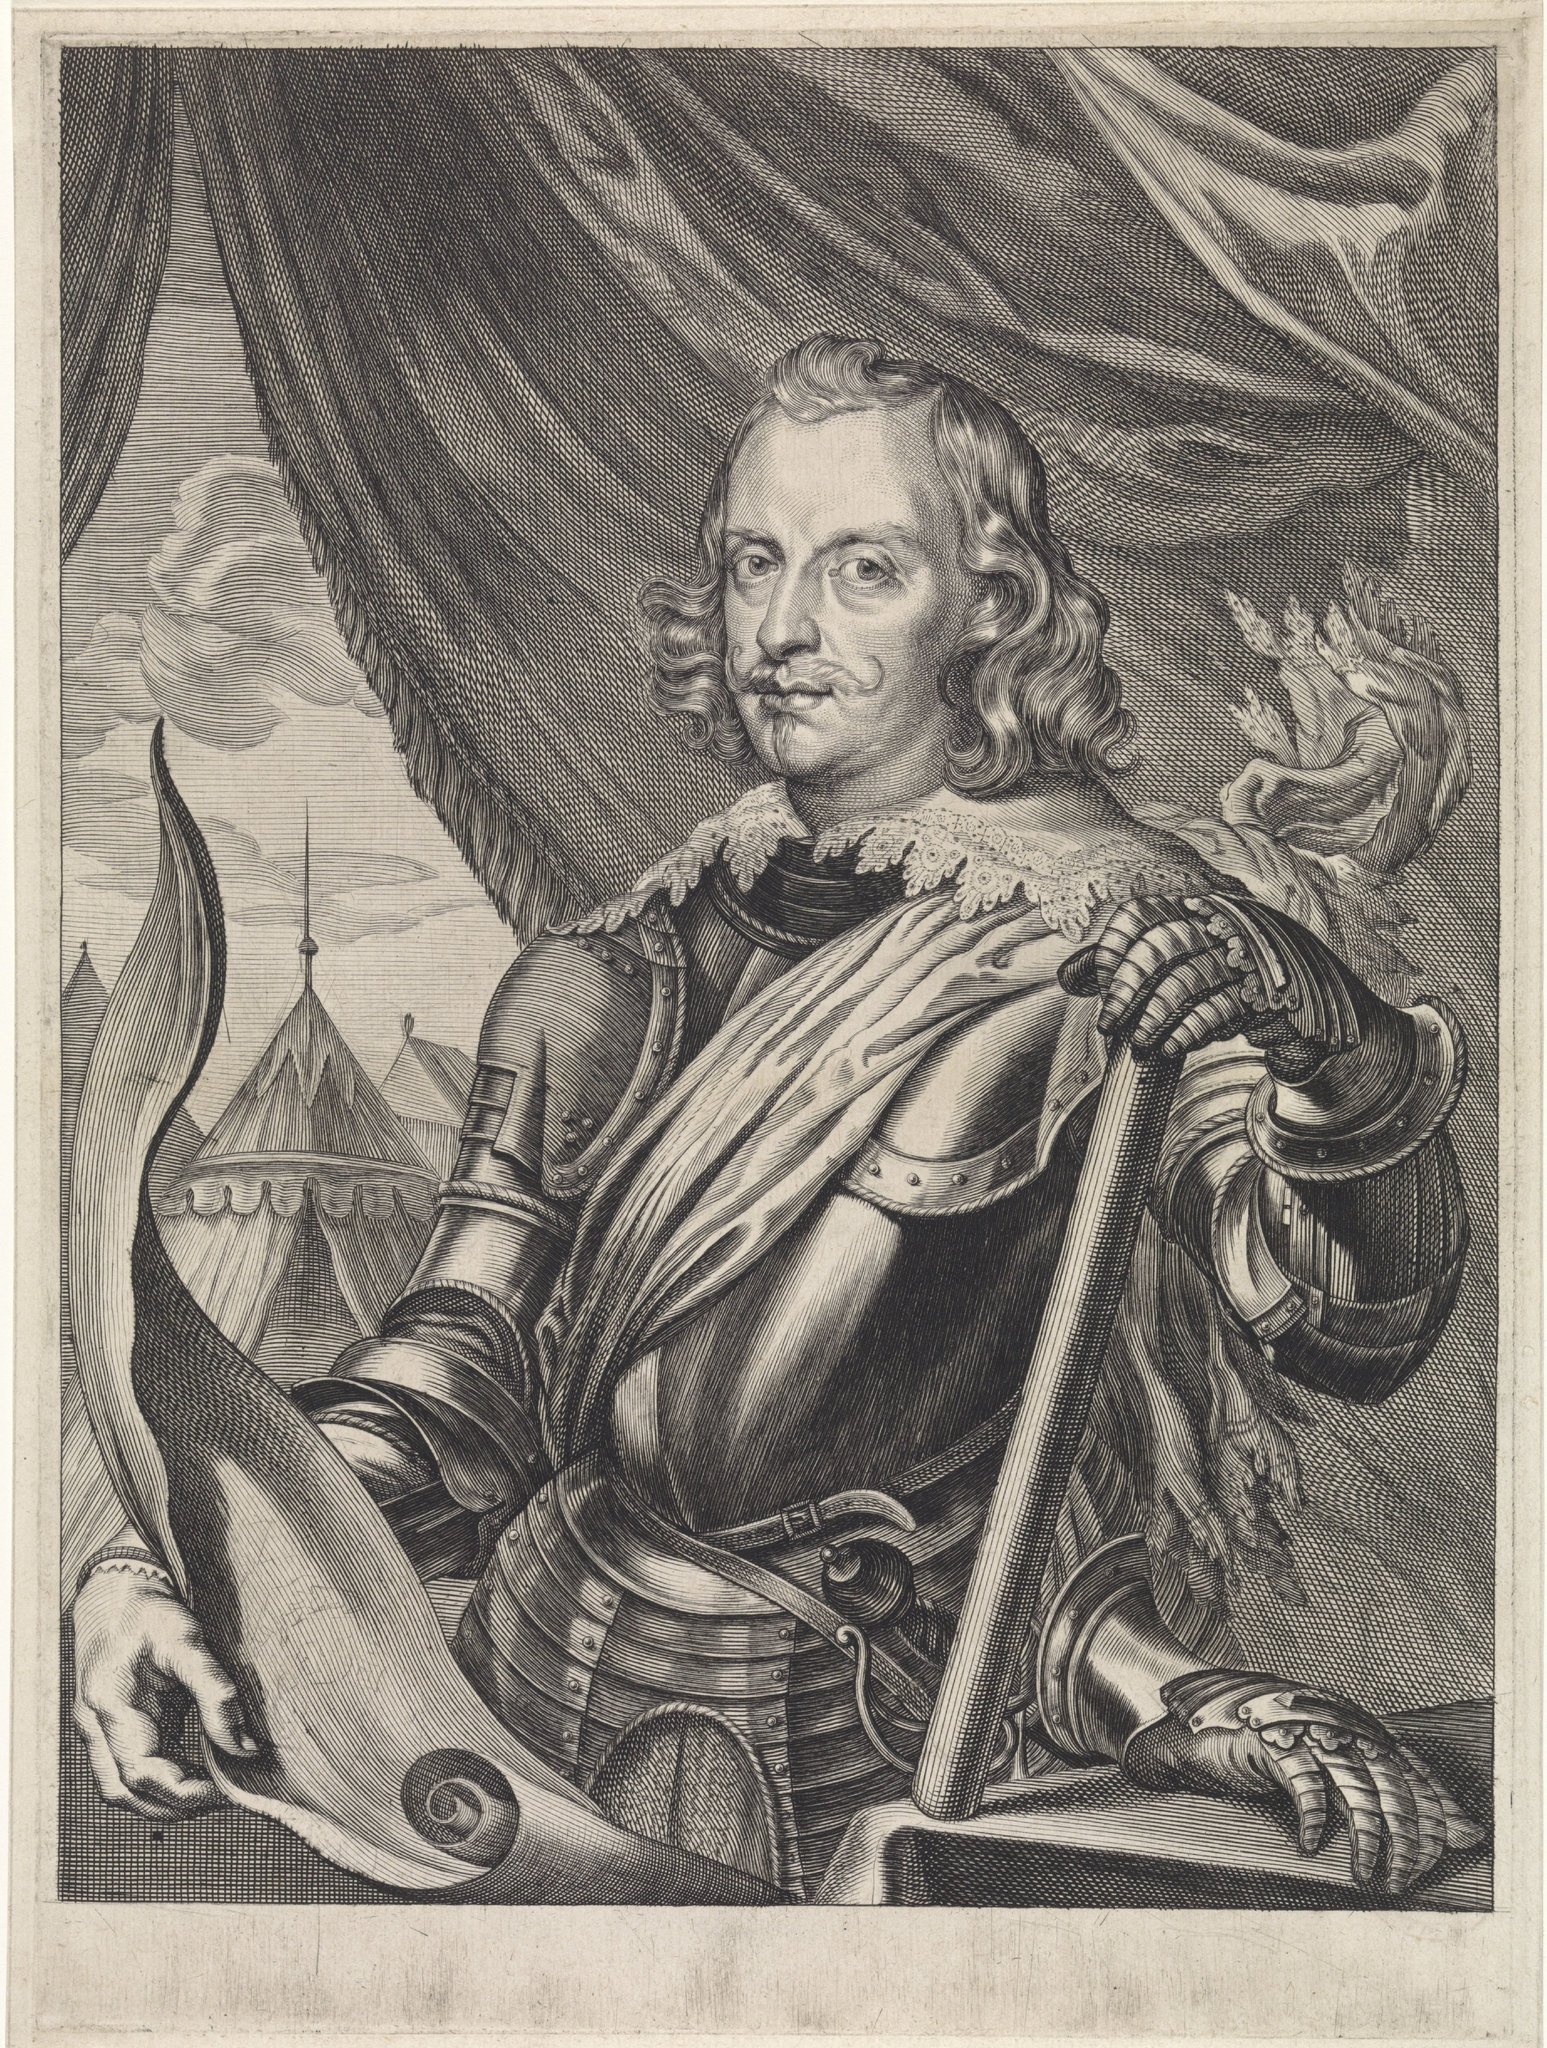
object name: print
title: Portret van Ferdinand van Oostenrijk, landvoogd der zuidelijke Nederlanden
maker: jacobus van schoor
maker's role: print maker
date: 1623-1636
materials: paper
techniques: engraving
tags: brussels, landvoogd der zuidelijke nederlanden ferdinand van oostenrijk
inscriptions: collector's mark: Lugt 240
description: Portret van Ferdinand van Oostenrijk, landvoogd der zuidelijke Nederlanden in harnas. Hij draagt een commandostaf in de ene en een vel papier in de andere hand.